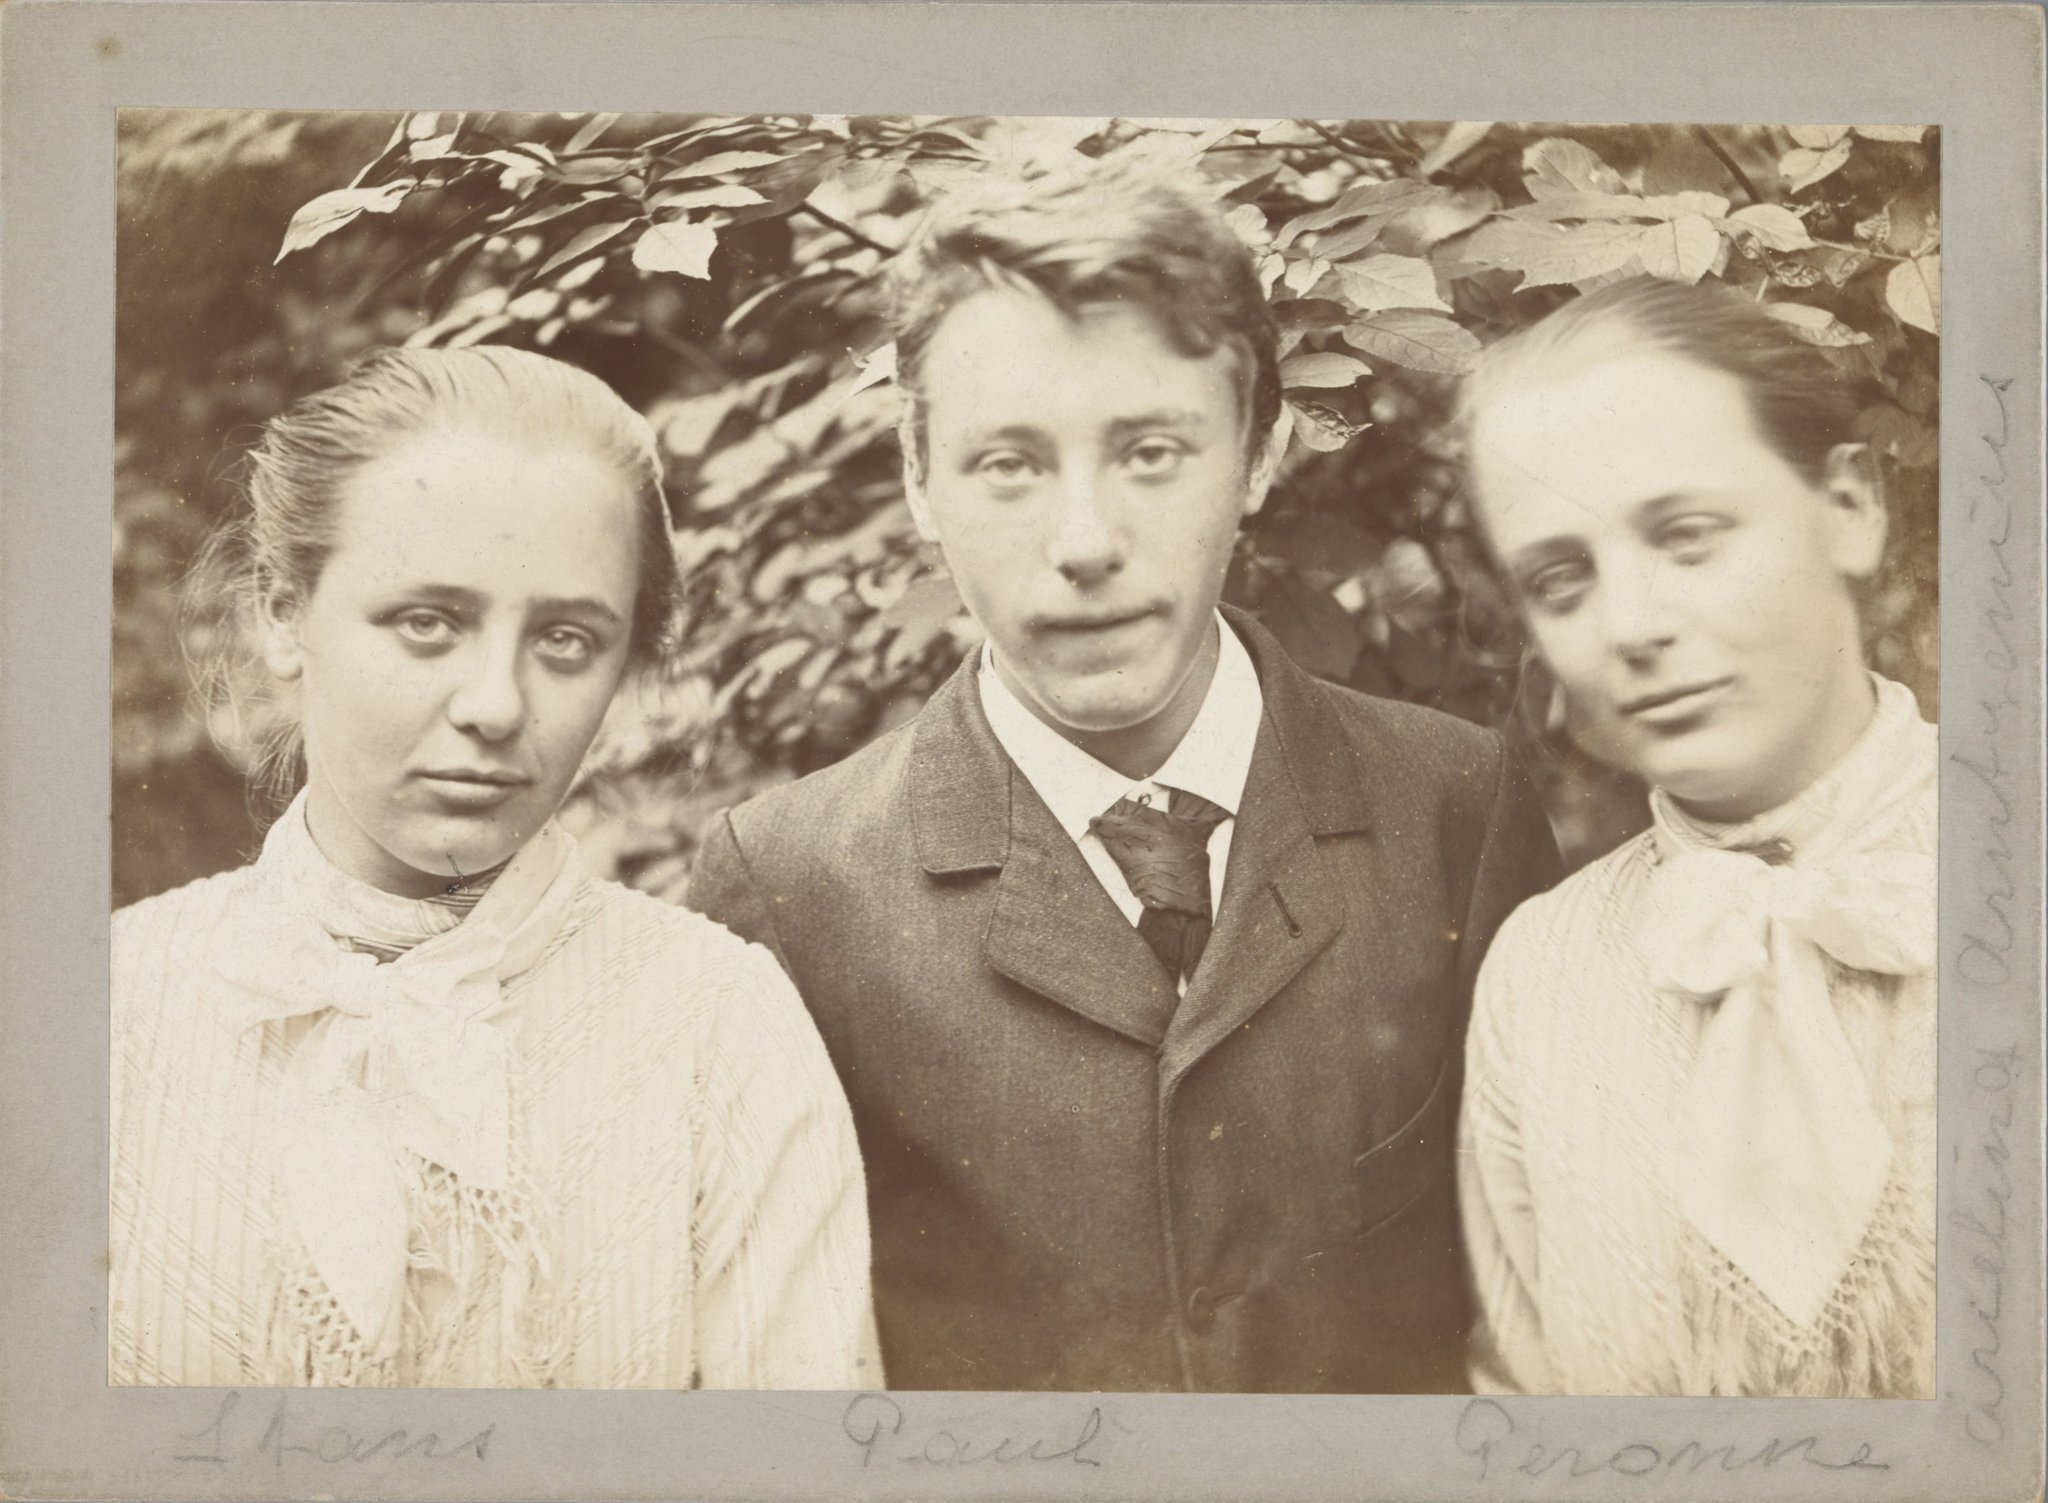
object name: photograph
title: Drieling Stans, Paul en Peronne Arntzenius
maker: willem witsen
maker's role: draughtsman, painter, print maker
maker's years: 1860-1923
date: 1860-1915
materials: cardboard, paper, photographic support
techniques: gelatin silver print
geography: amsterdam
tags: péronne arntzenius